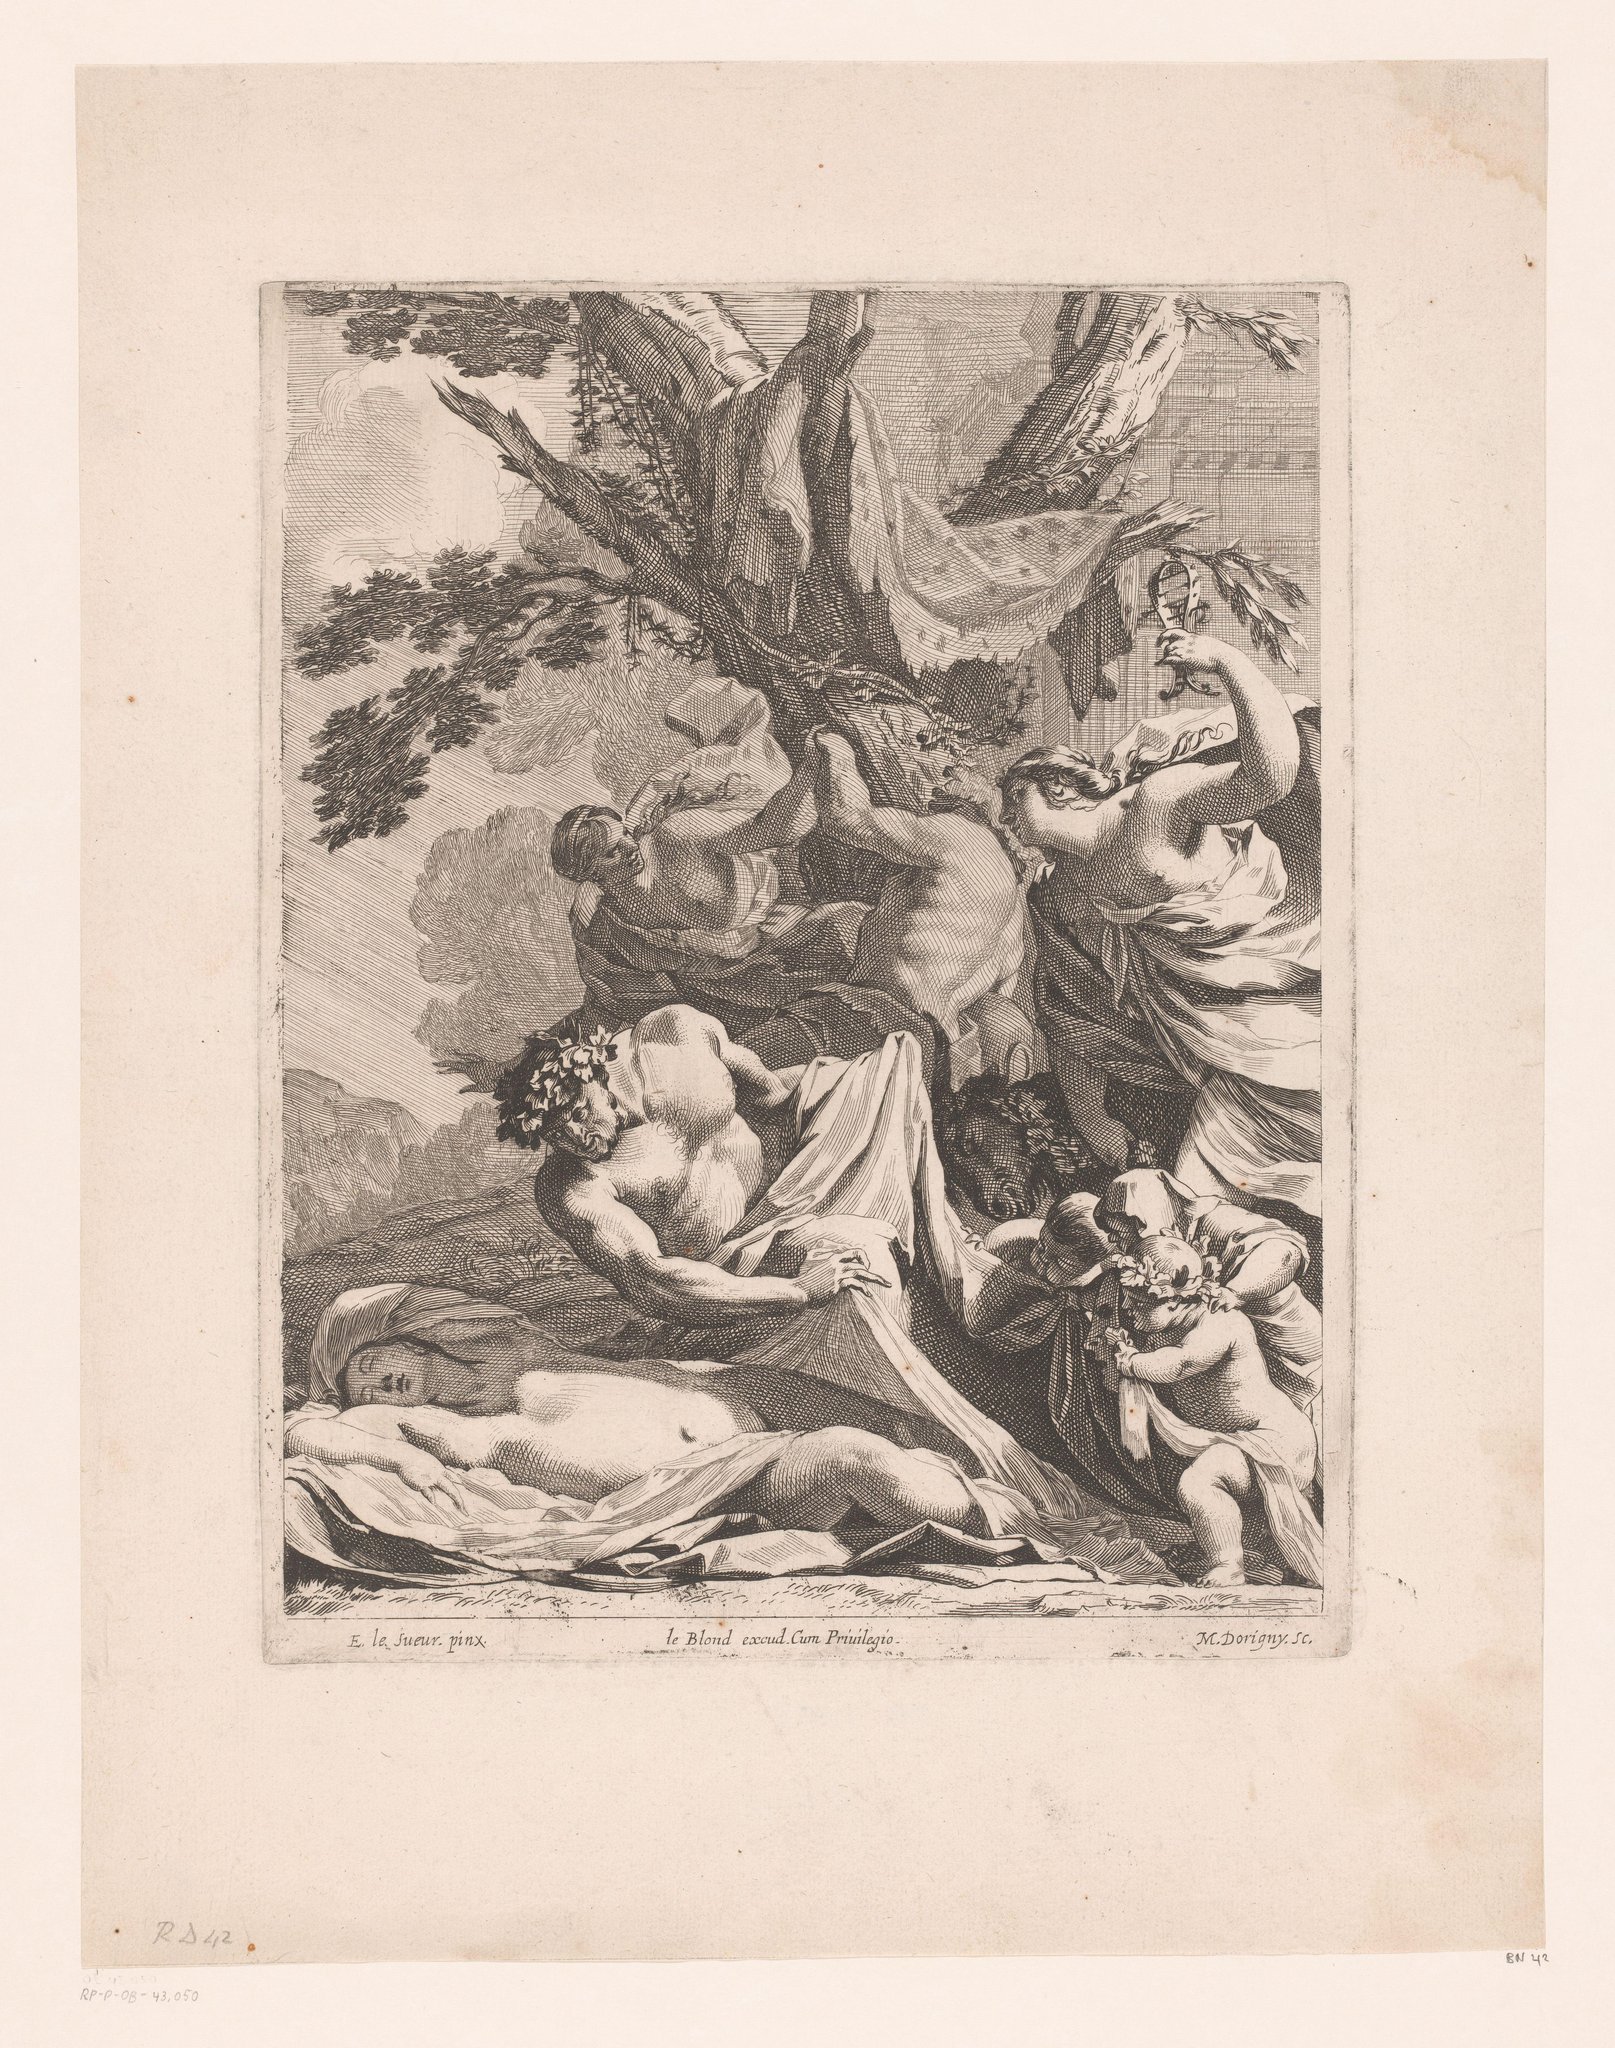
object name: print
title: Bacchanaal met slapende bacchante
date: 1626-1665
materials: paper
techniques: engraving, etching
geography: france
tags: sleeping on the ground - bb - out of doors, maenad(s), female bacchant(es), male bacchant(es)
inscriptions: collector's mark: Lugt 240